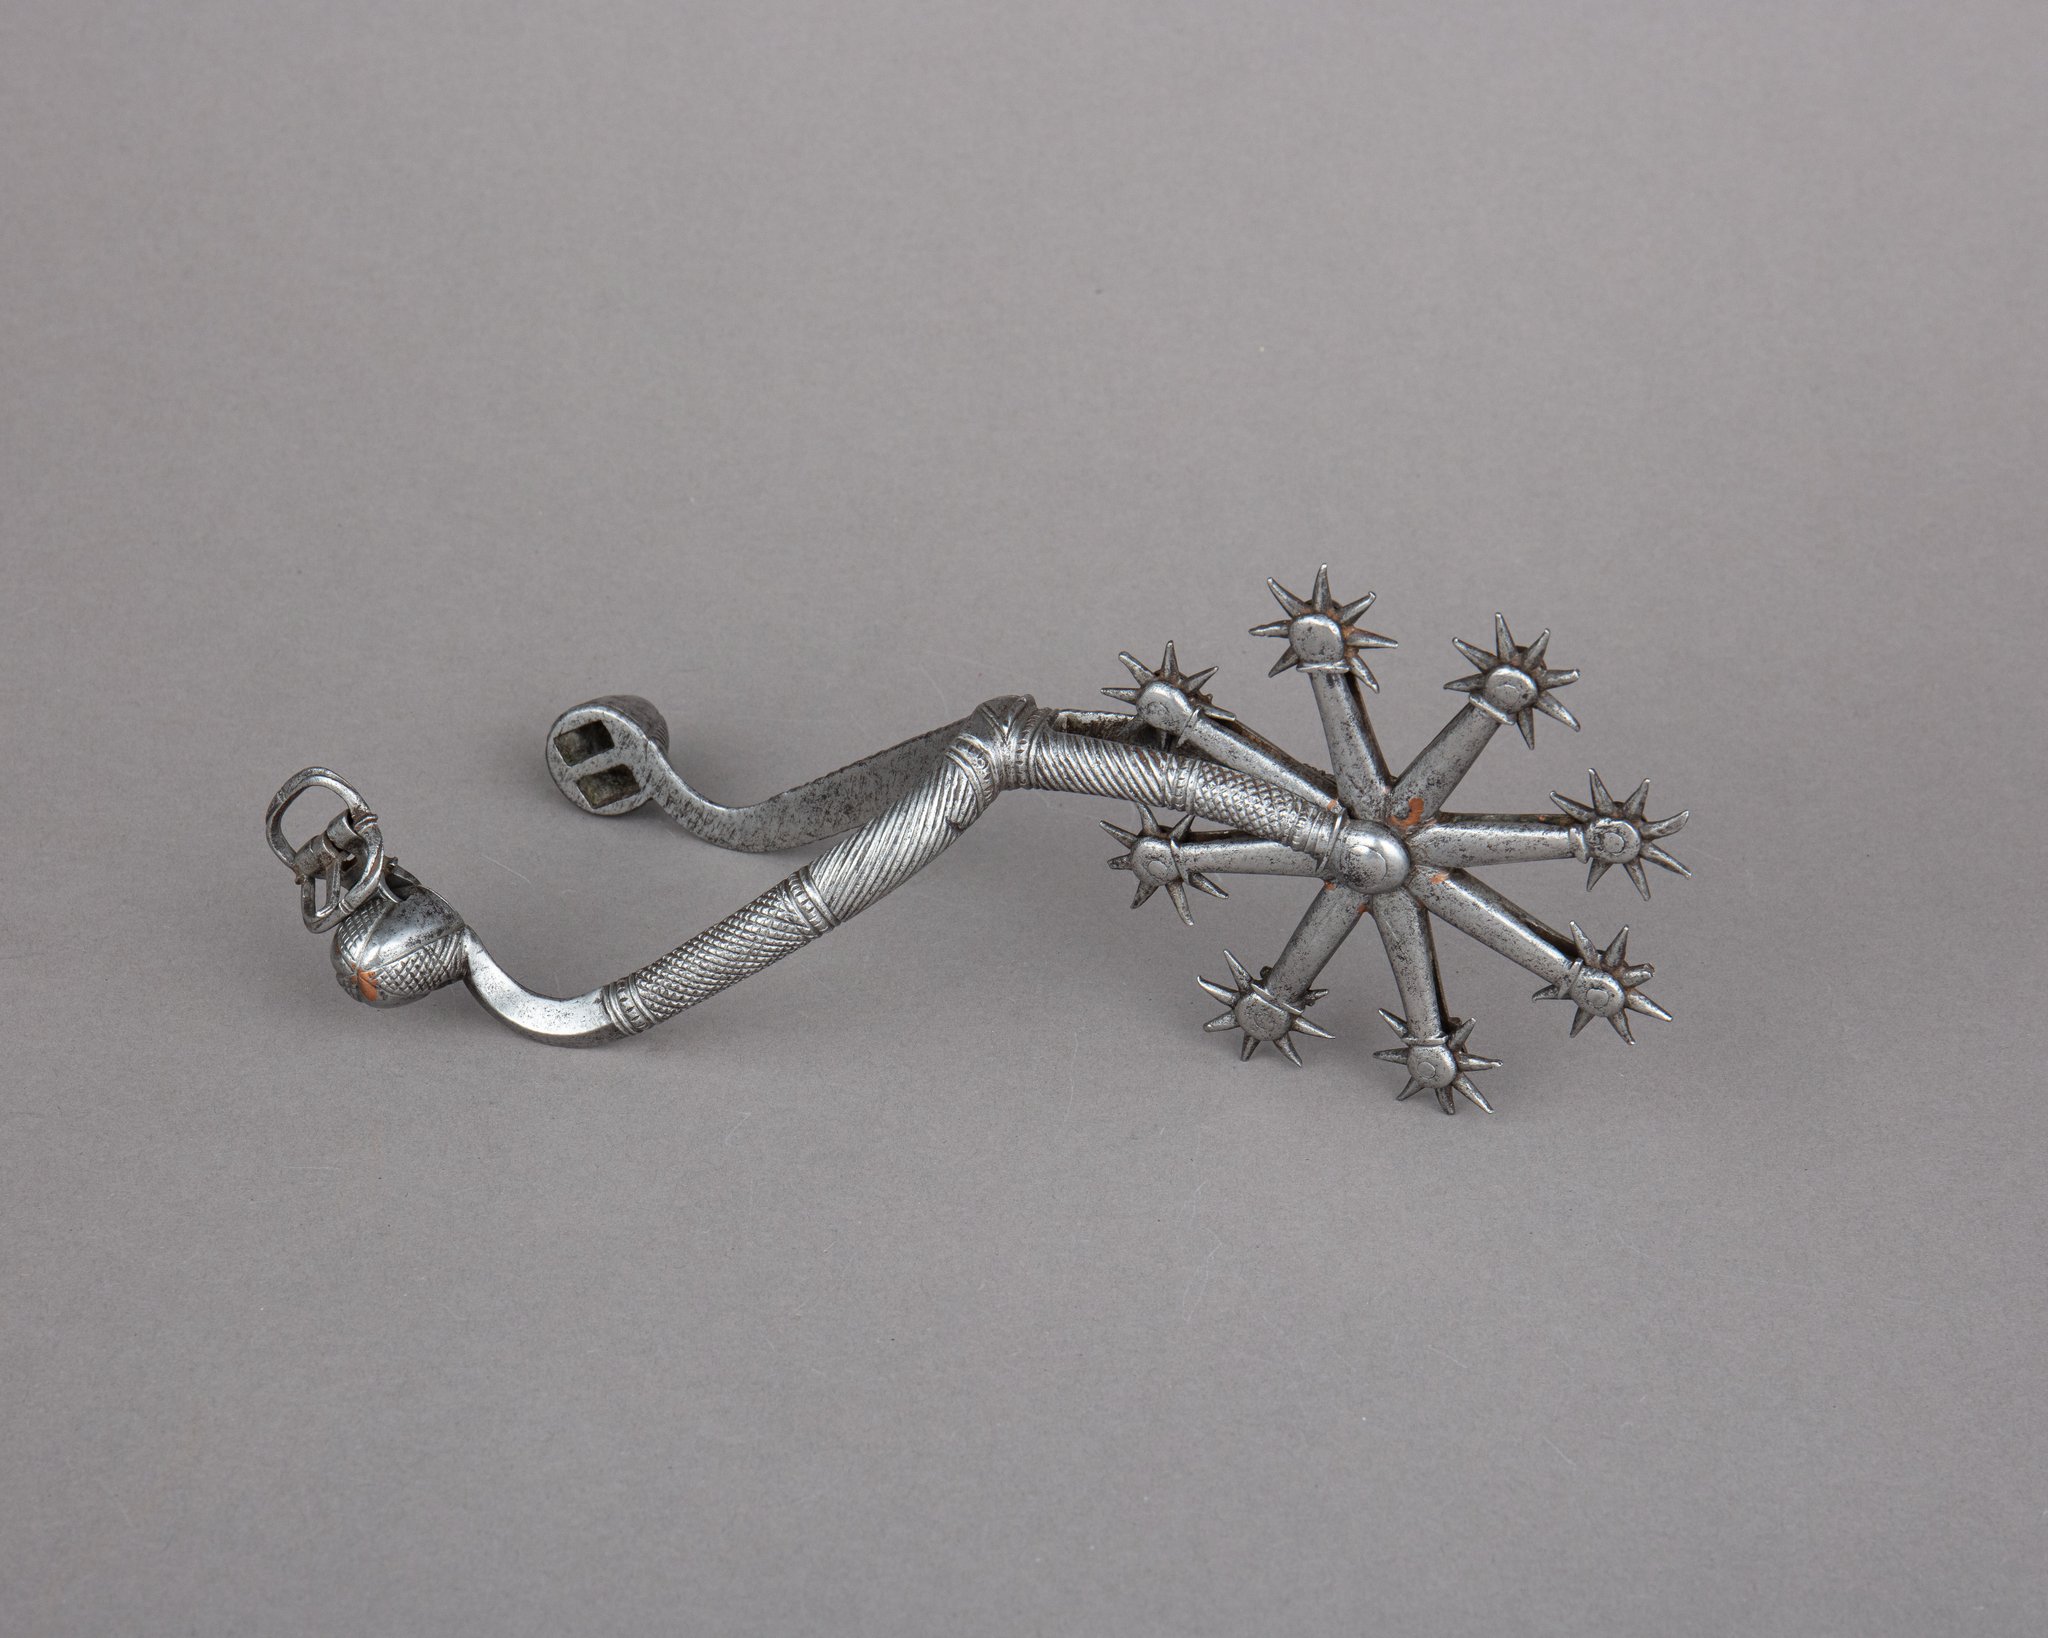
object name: spur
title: Rowel Spur (Left)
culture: german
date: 1551-1600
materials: copper, metal alloy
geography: germany